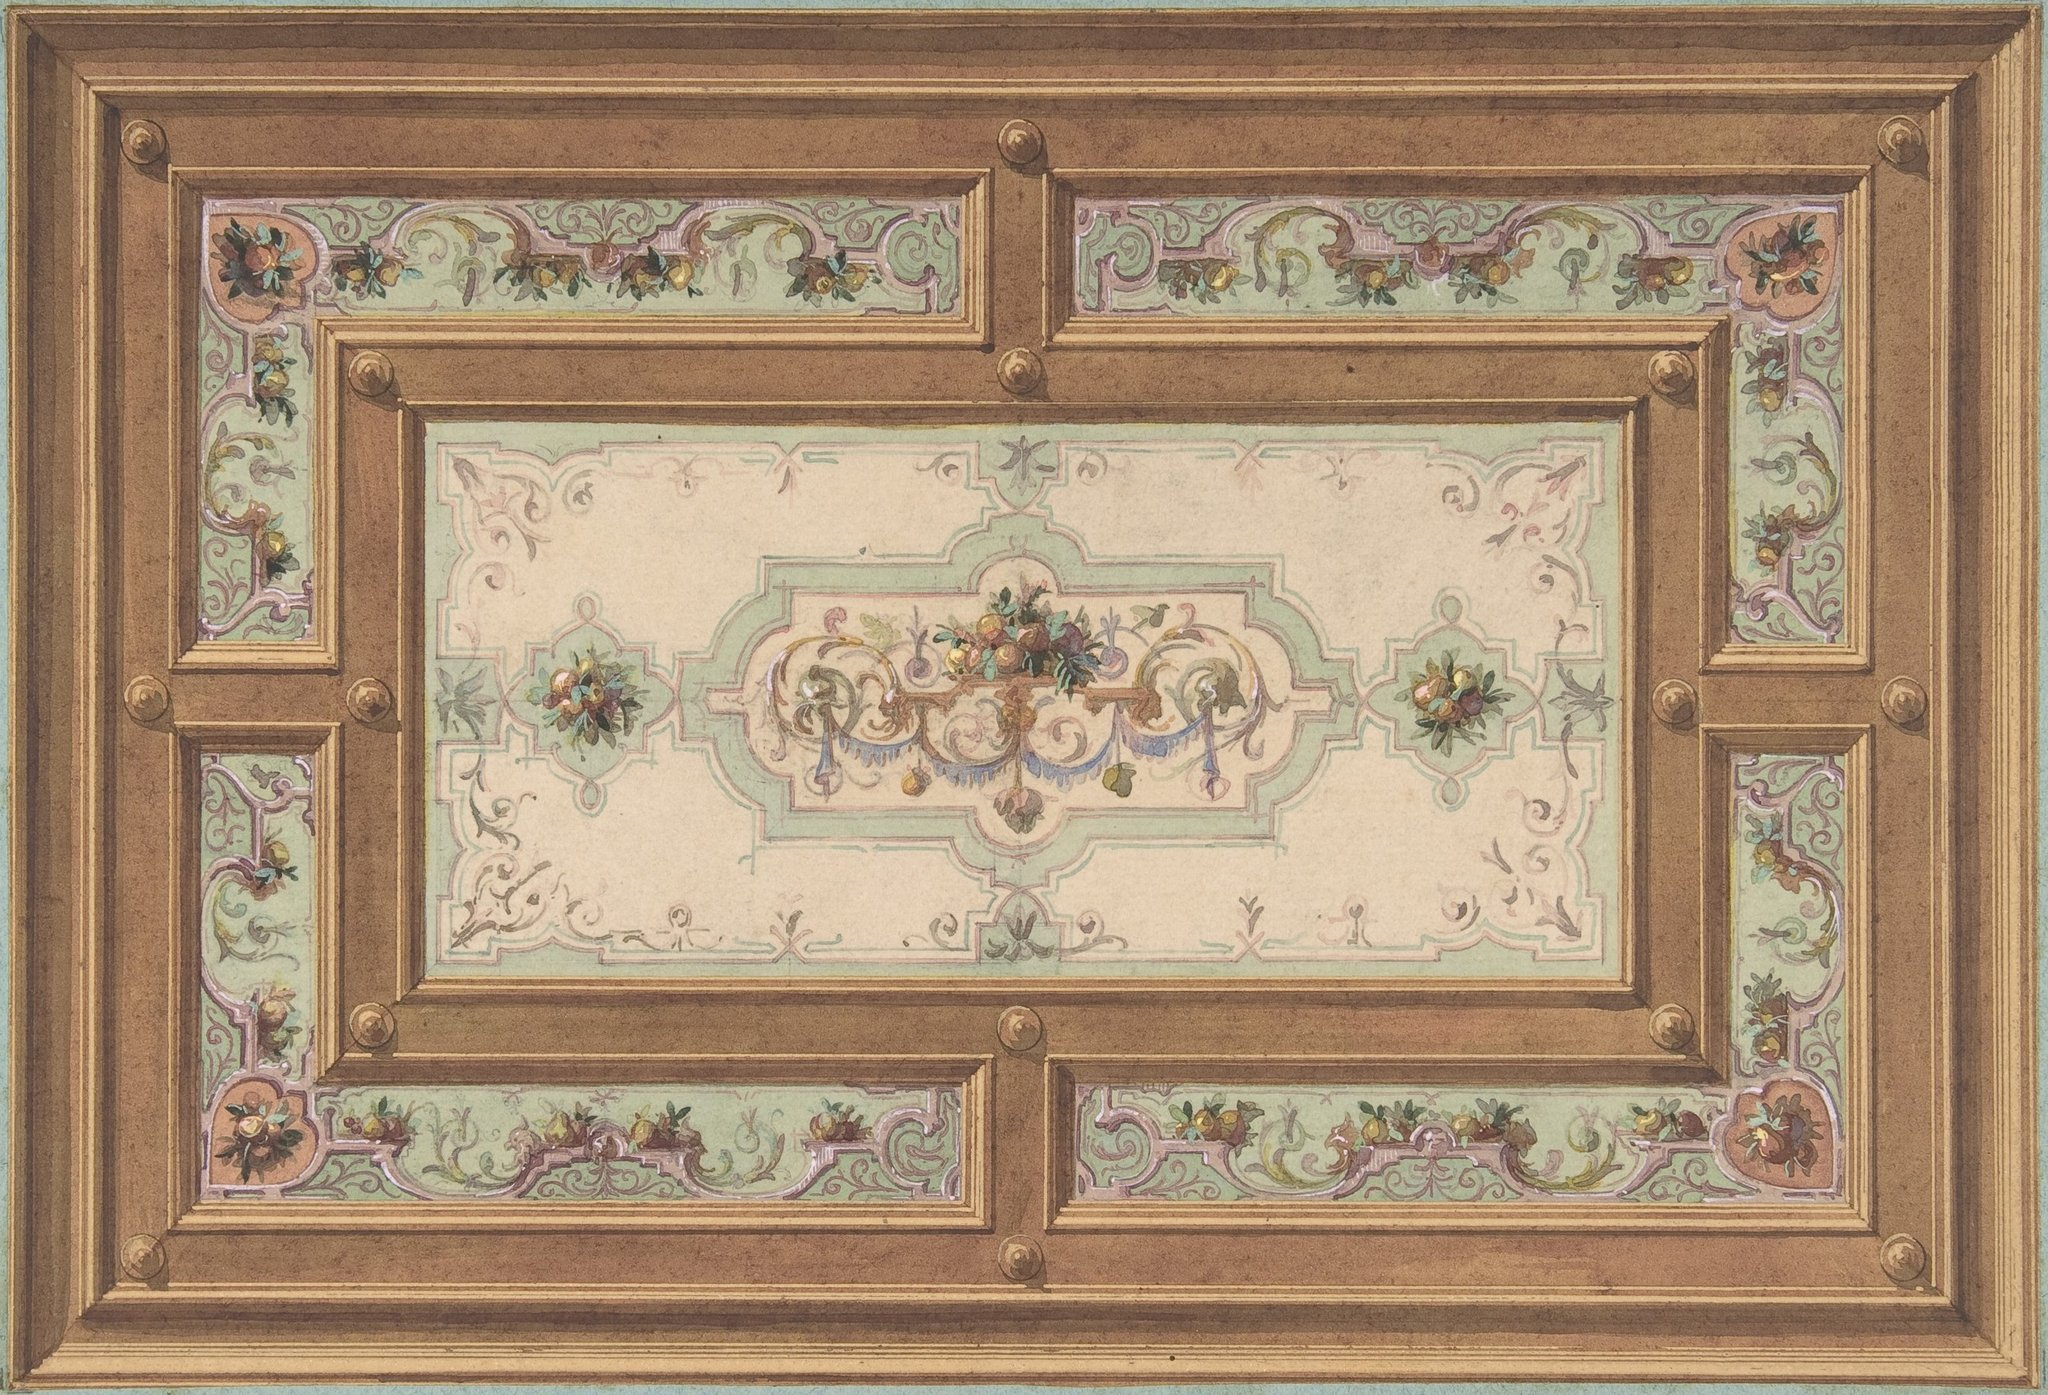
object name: drawing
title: Design for a Painted Ceiling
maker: jules-edmond-charles lachaise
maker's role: artist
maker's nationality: french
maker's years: 1897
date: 1851-1900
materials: gouache, ink, watercolor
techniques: pen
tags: flowers,ceilings